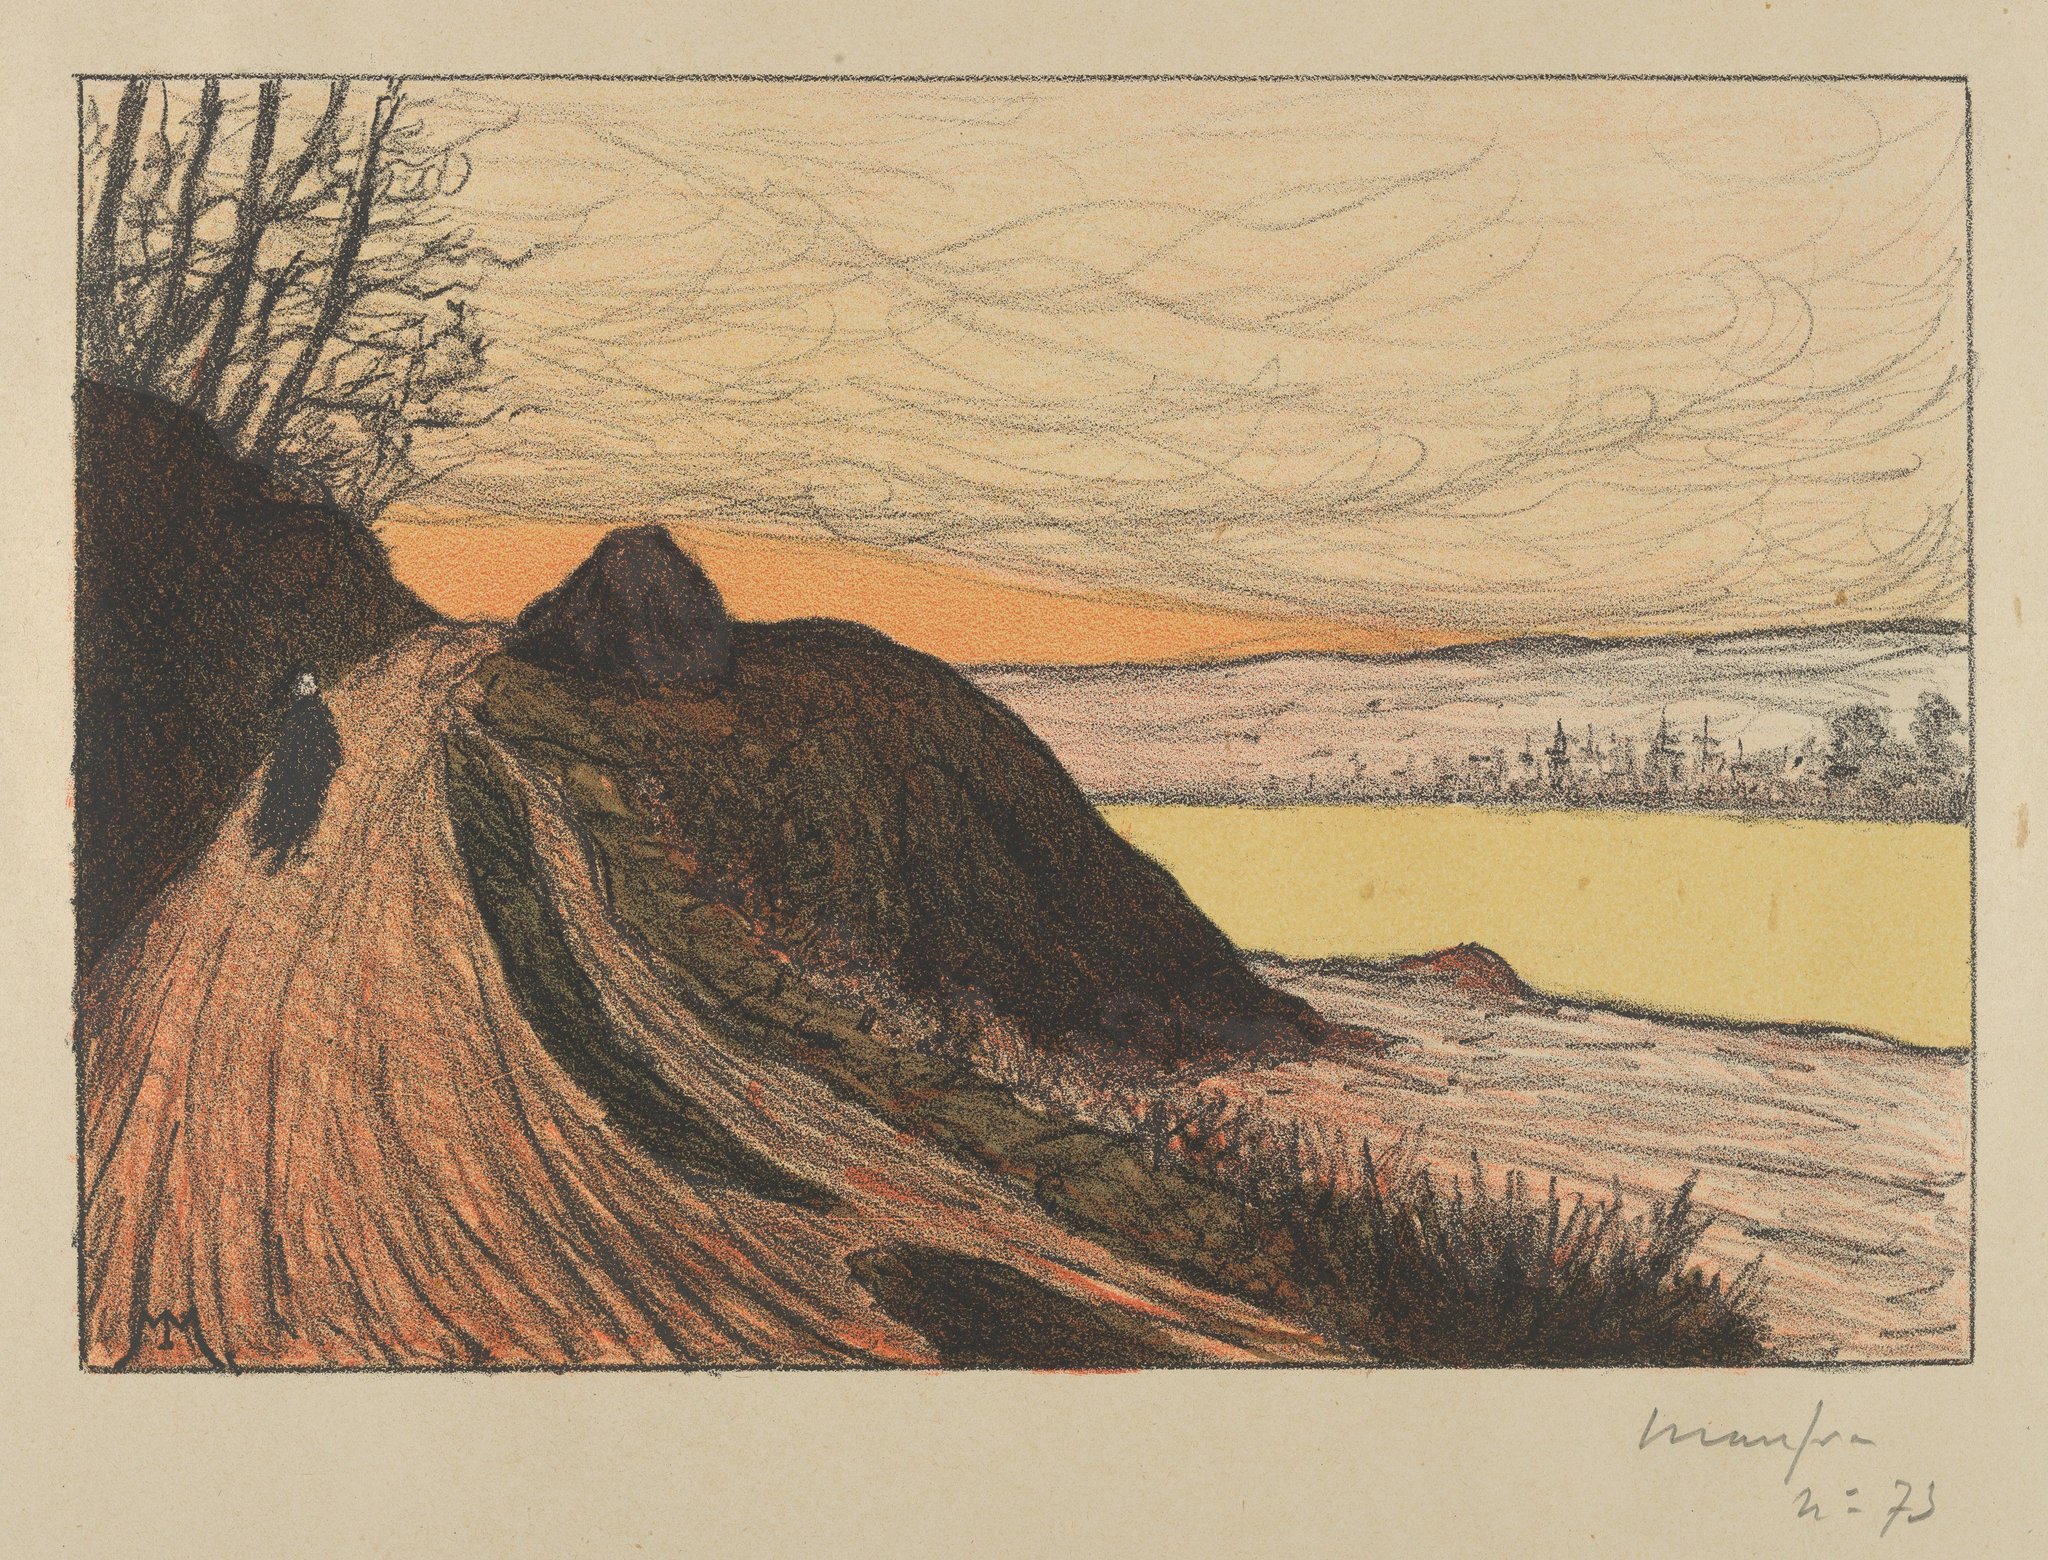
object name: print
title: The Road from Gaud (La Route de Gaud), from "L'Estampe Originale"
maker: maxime maufra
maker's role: artist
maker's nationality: french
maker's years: 1861-1918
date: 1893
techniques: lithograph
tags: roads